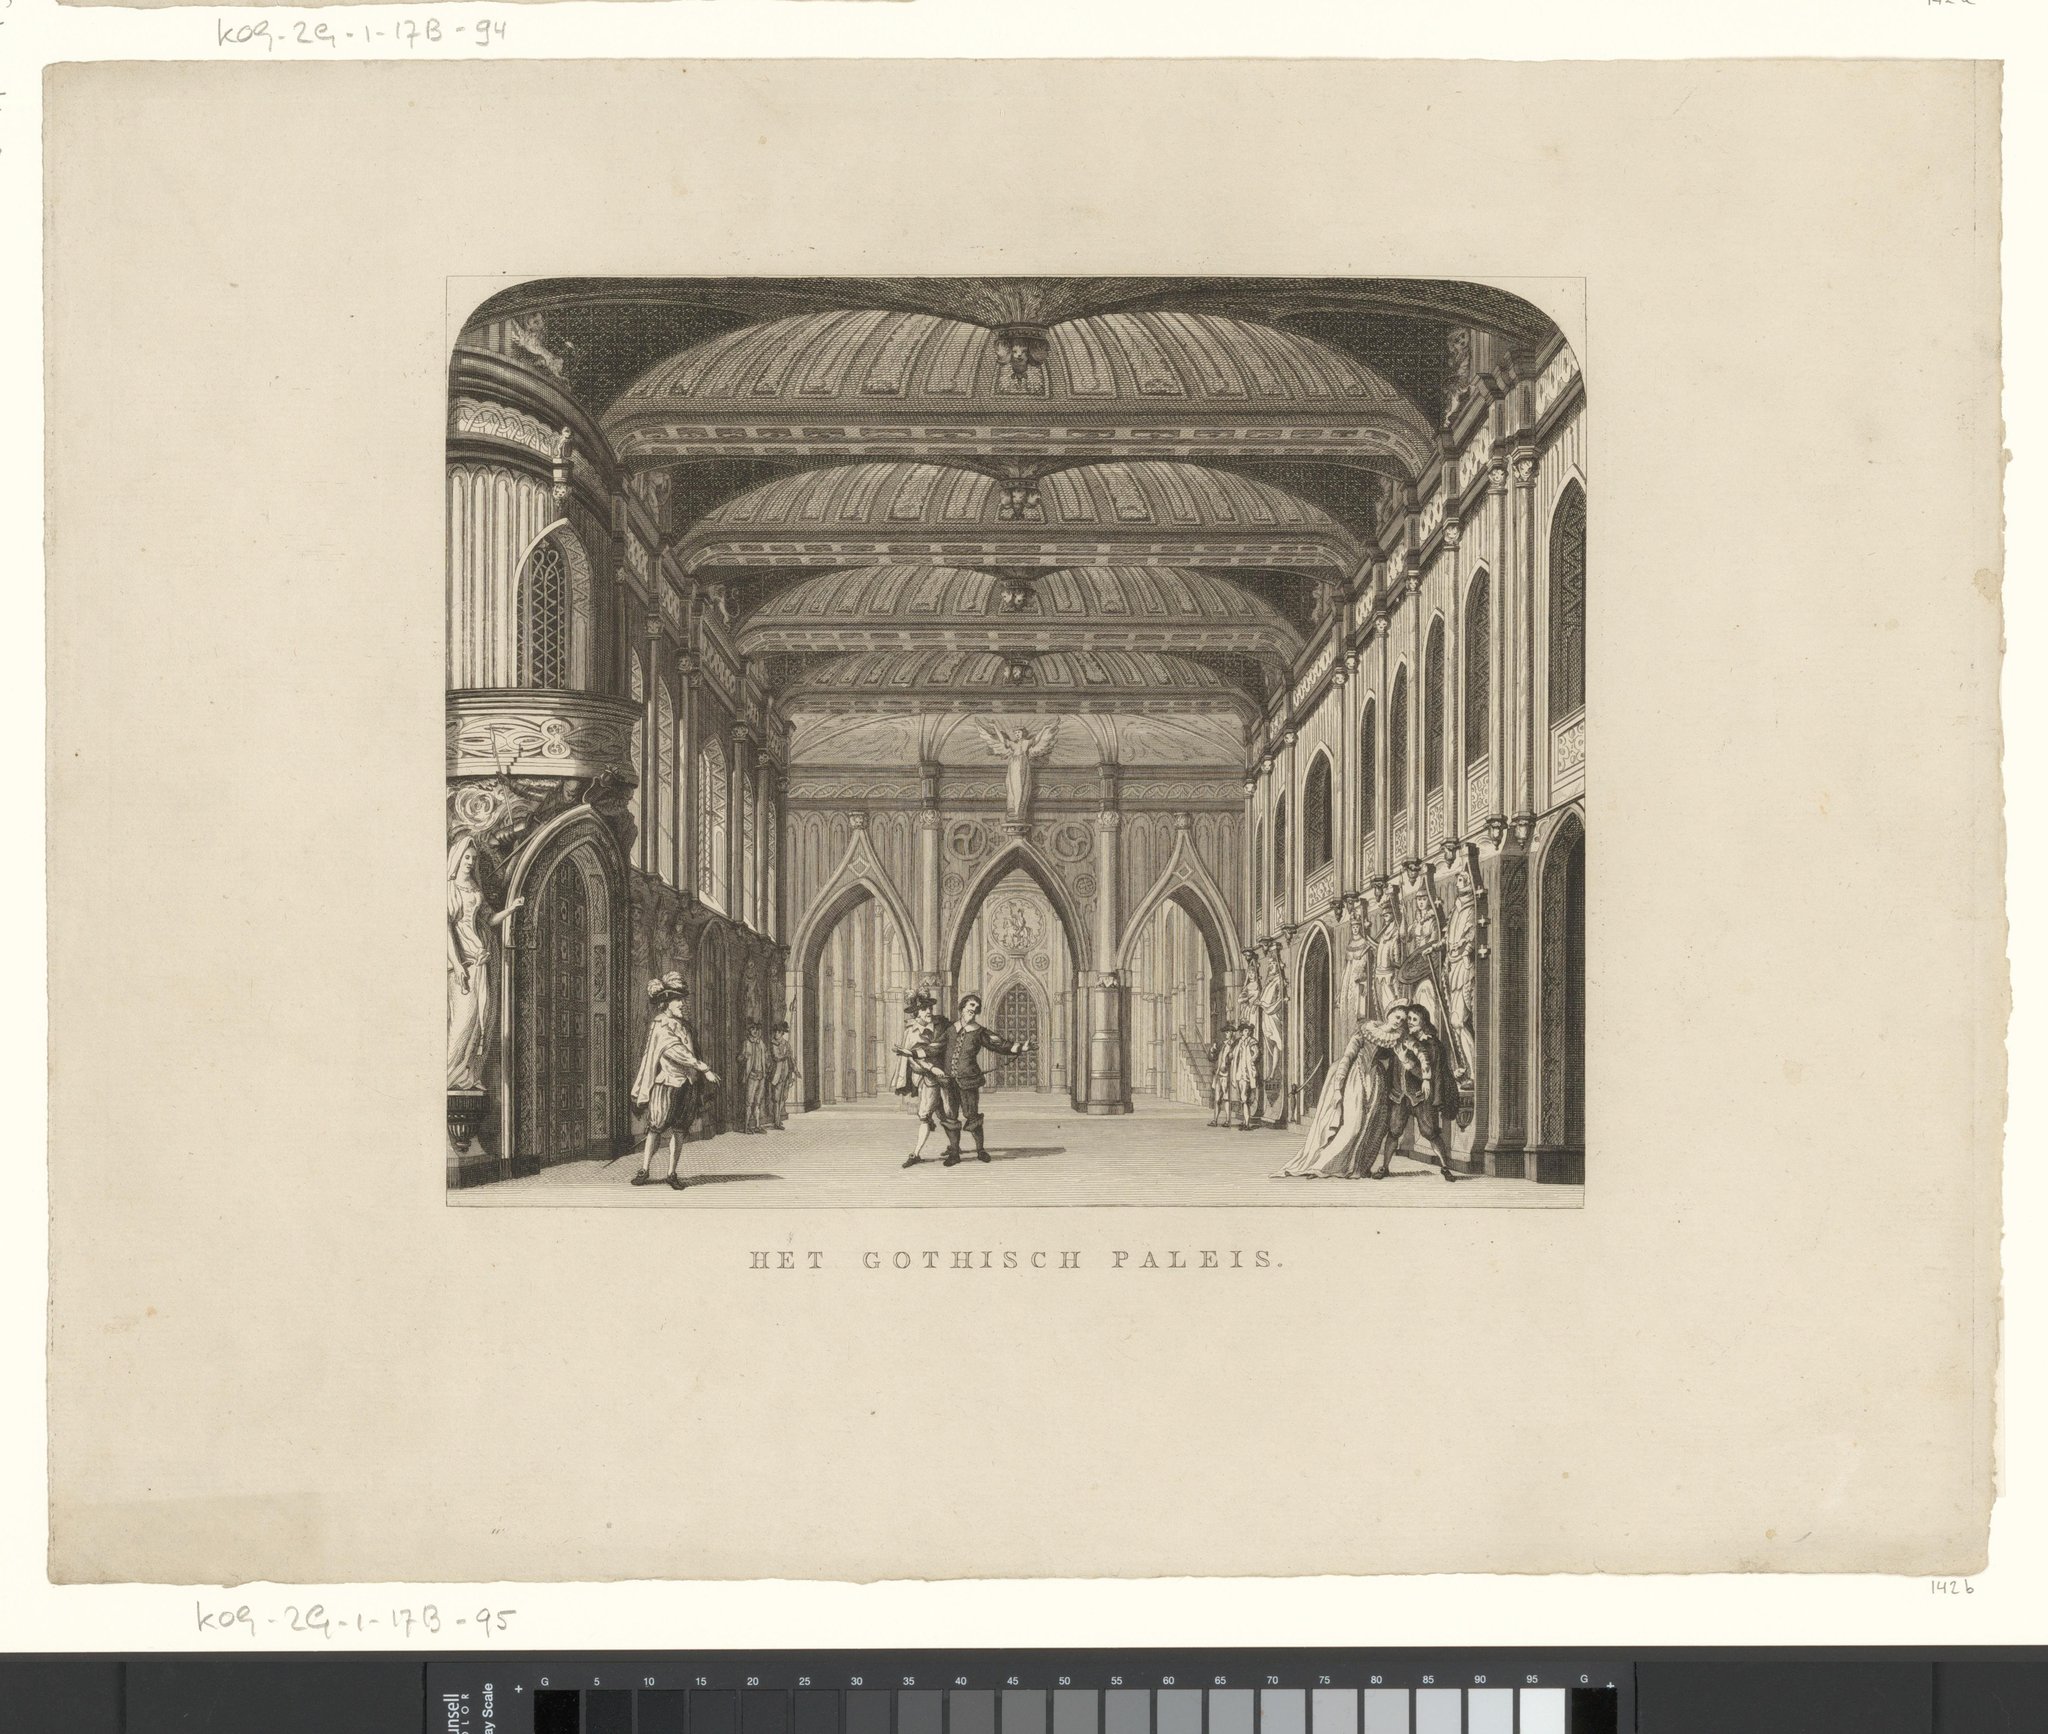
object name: print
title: Toneeldecor: Het Gothisch Paleis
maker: pieter hendrik jonxis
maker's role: print maker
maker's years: 1757-1843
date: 1785-1788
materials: paper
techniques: etching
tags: theatre, theatrical performance, stage design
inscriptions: collector's mark: Lugt 1641, stamp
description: Het coulissendecor Het Gothisch Paleis, met scène uit Jacob Simonszoon de Ryk. Aparte afdruk van alleen het decor, zonder de passe-partout met het toneel en de zaal. Behorend bij de serie van veertien toneeldecors van de nieuwe Amsterdamse Schouwburg, 1787-1794. Onderwerpsrubrieken binnen de Atlas Zeden en Gewoonten: Schoone kunsten, Tooneel, Decors voor de Schouwburg.